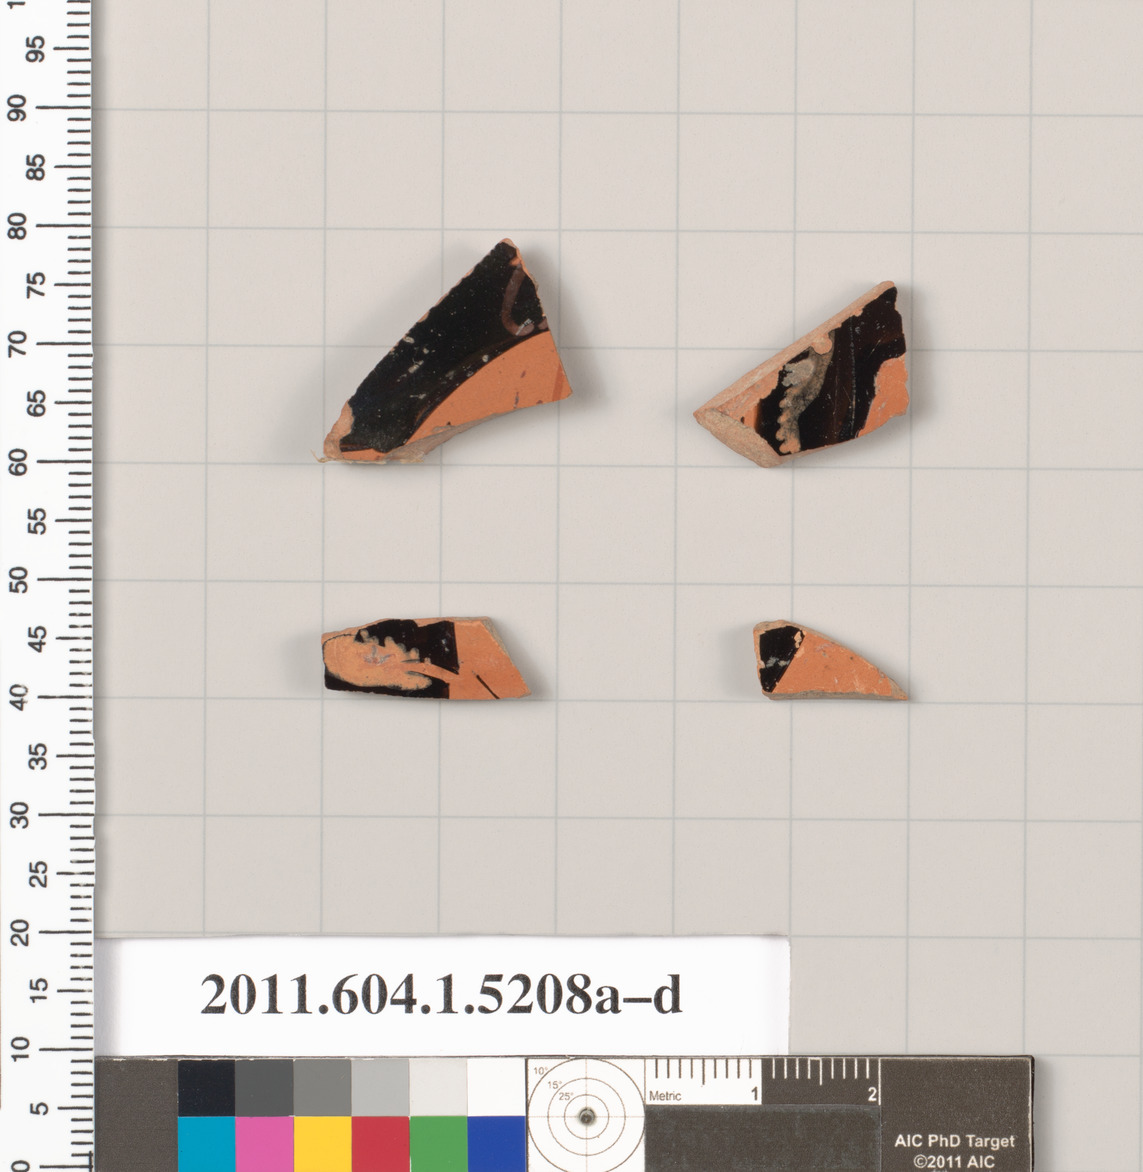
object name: kylix fragment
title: Terracotta fragments of kylikes (drinking cups)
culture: greek, attic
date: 500-476 BCE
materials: terracotta